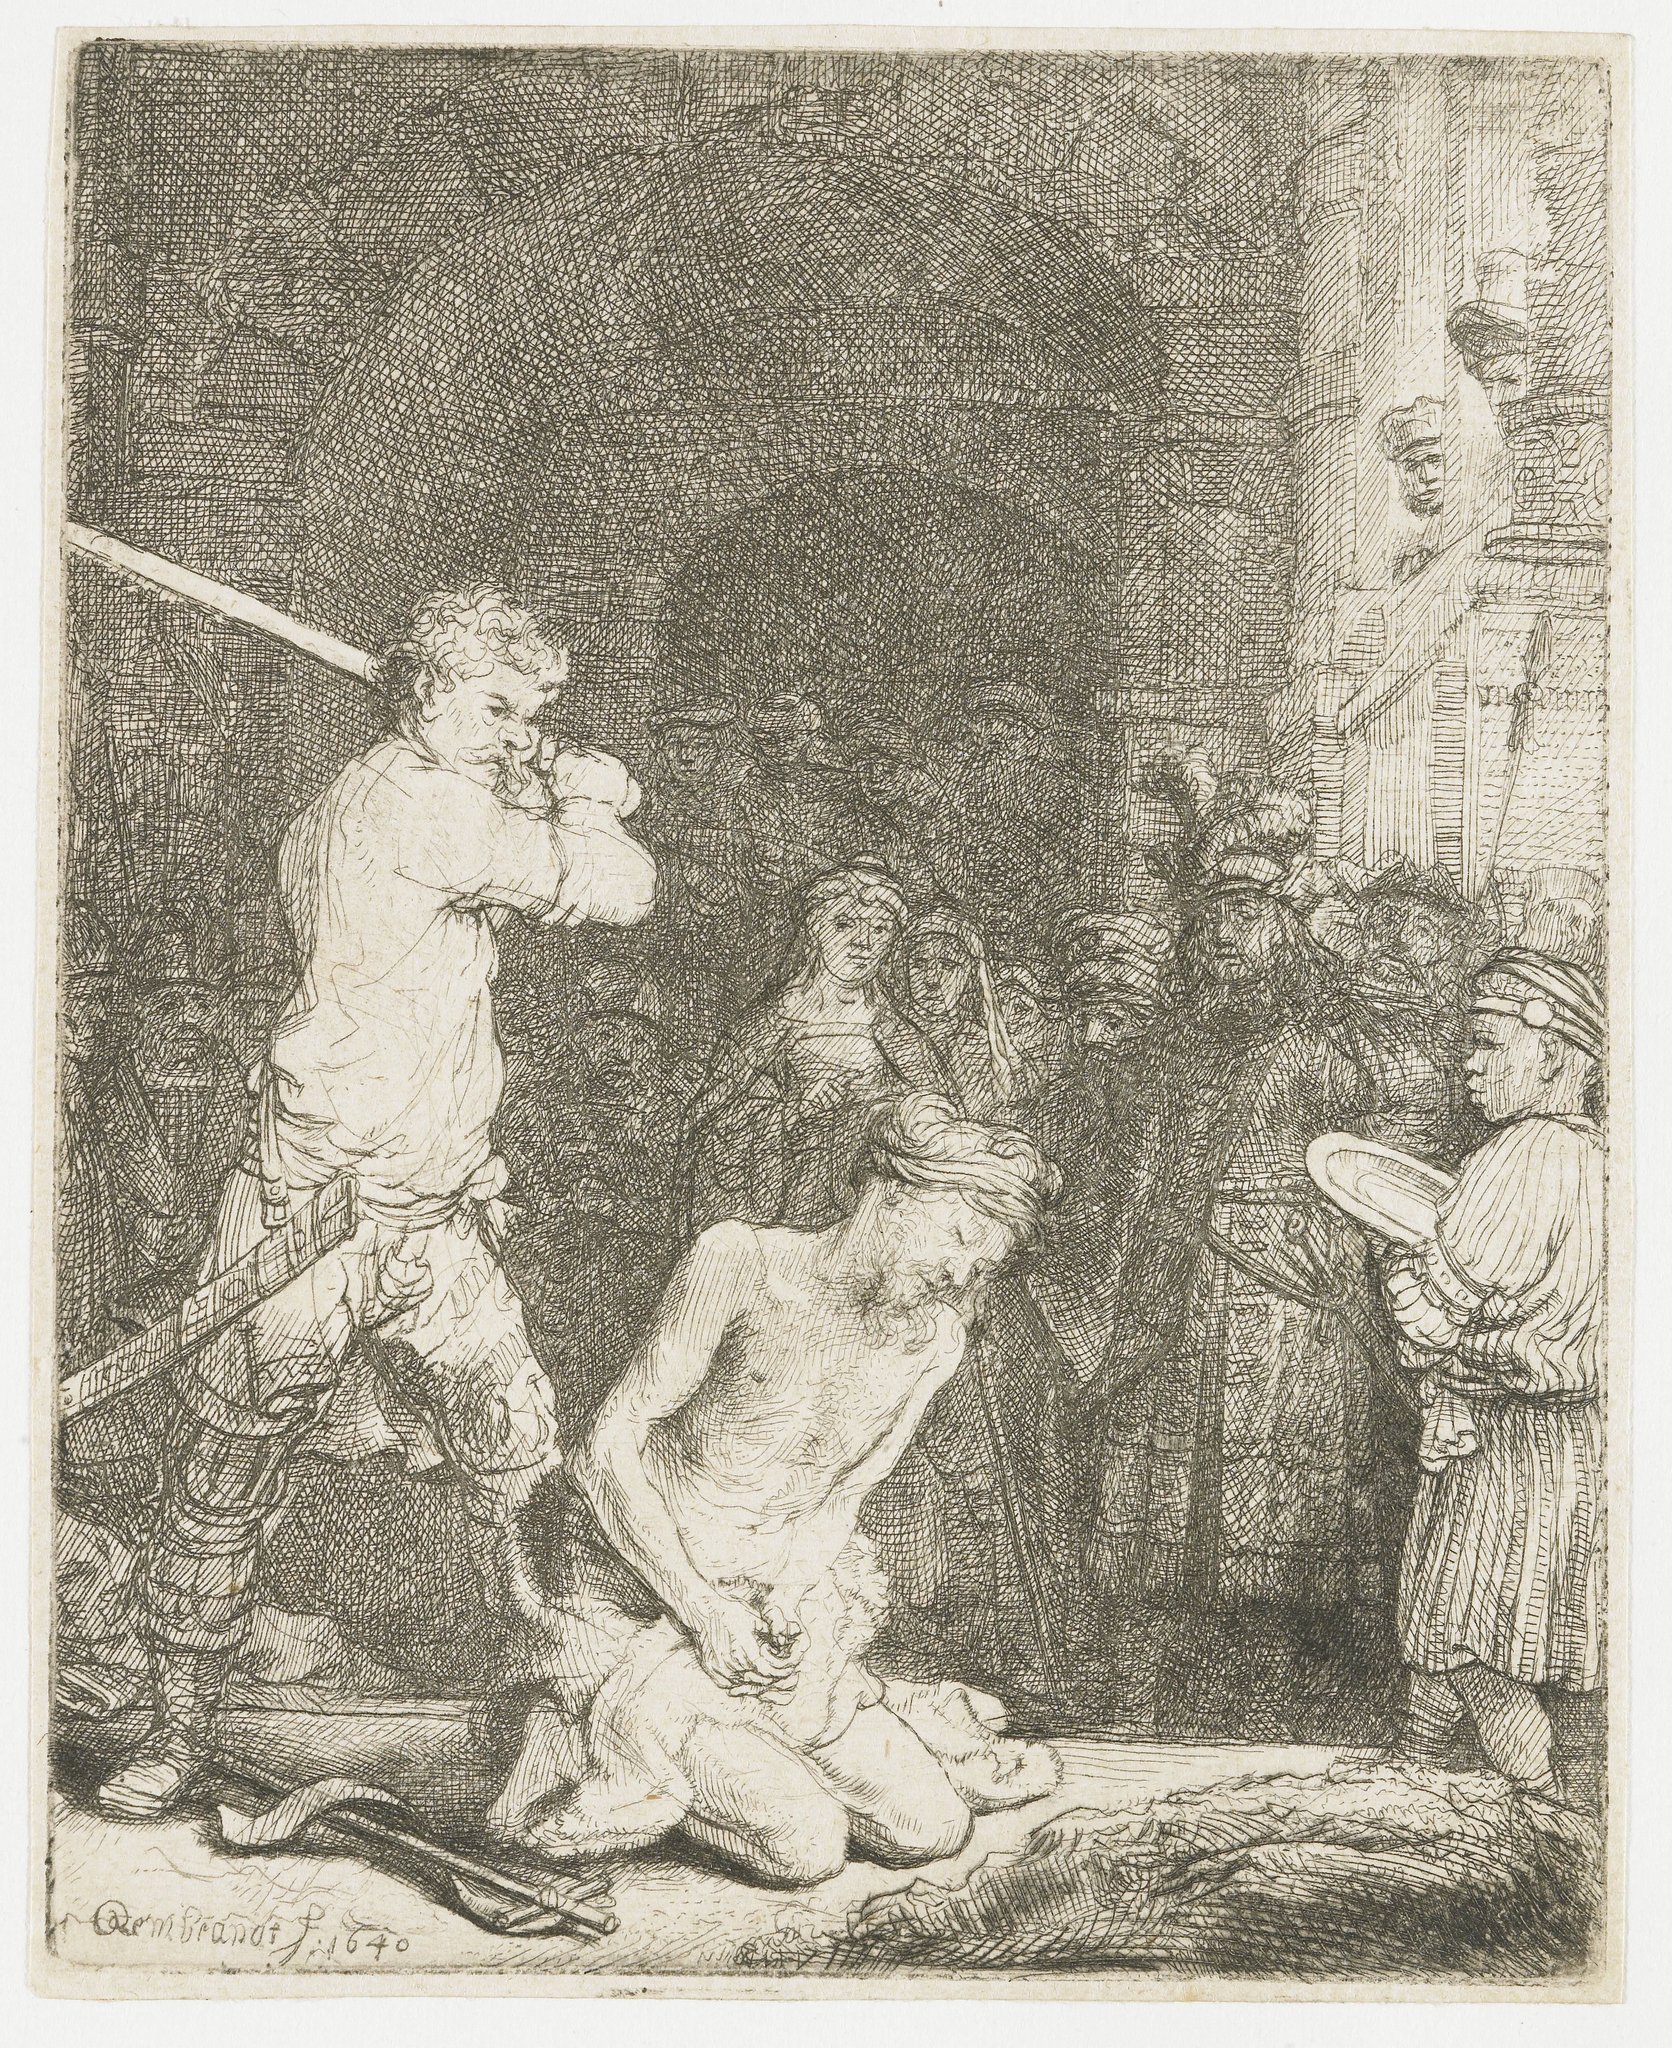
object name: print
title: The Beheading of John the Baptist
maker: rembrandt van rijn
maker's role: draughtsman, painter, print maker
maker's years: 1606-1669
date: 1640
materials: paper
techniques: drypoint, etching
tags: the beheading of john the baptist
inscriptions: signature and date: ‘Rembrandt f. 1640’, collector's mark: Lugt 240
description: John the Baptist, one of the proclaimers of the coming of the Messiah, was venerated by the people as a prophet. He was imprisoned when he publicly criticized King Herod’s incestuous marriage. At Herod’s birthday banquet, the king’s daughter Salome danced so beautifully that he granted her a wish. She asked for the head of John the Baptist on a platter. And so it came to pass.